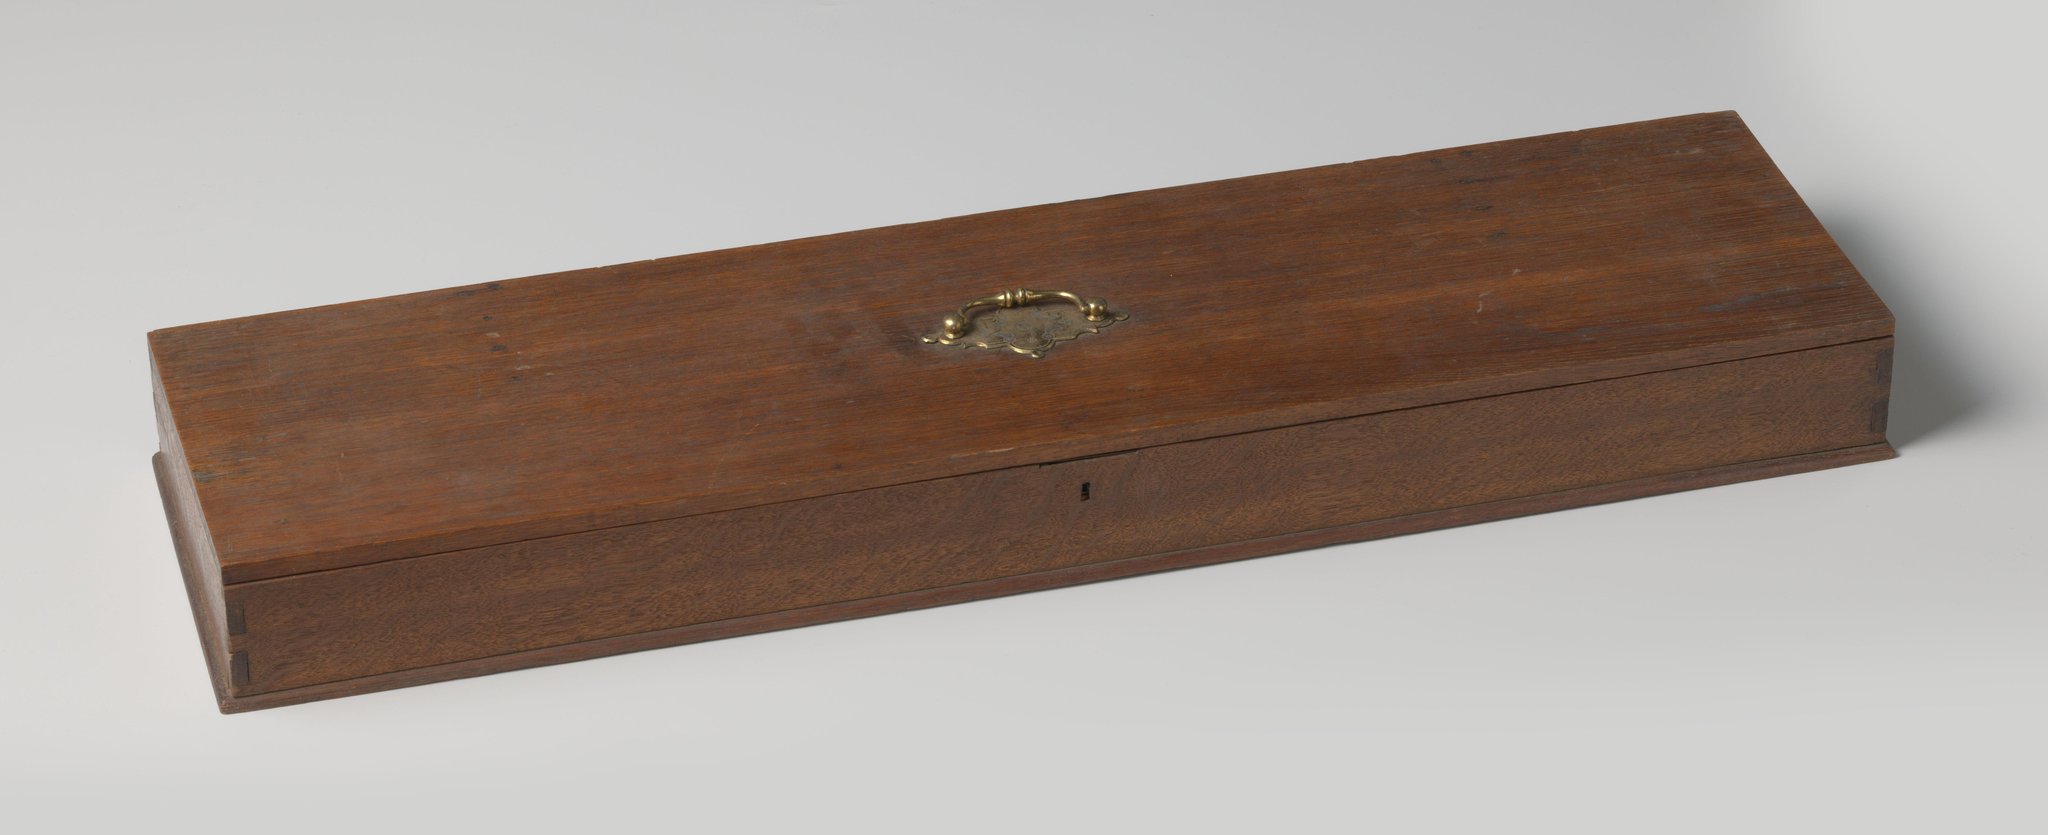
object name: peepshow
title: kijkkast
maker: Anonymous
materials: wood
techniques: woodworking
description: Kijkkast, de binnenkant is bekleed met lichtblauw papier met bladmotieven. Aan de voorkant is een inklapbaar vergrootglas aangebracht. De binnenkant bestaat verder uit inklapbare wanden. Op het deksel is een goudkleurig hengsel bevestigd. Voorkant een slot (sleutel ontbreekt).